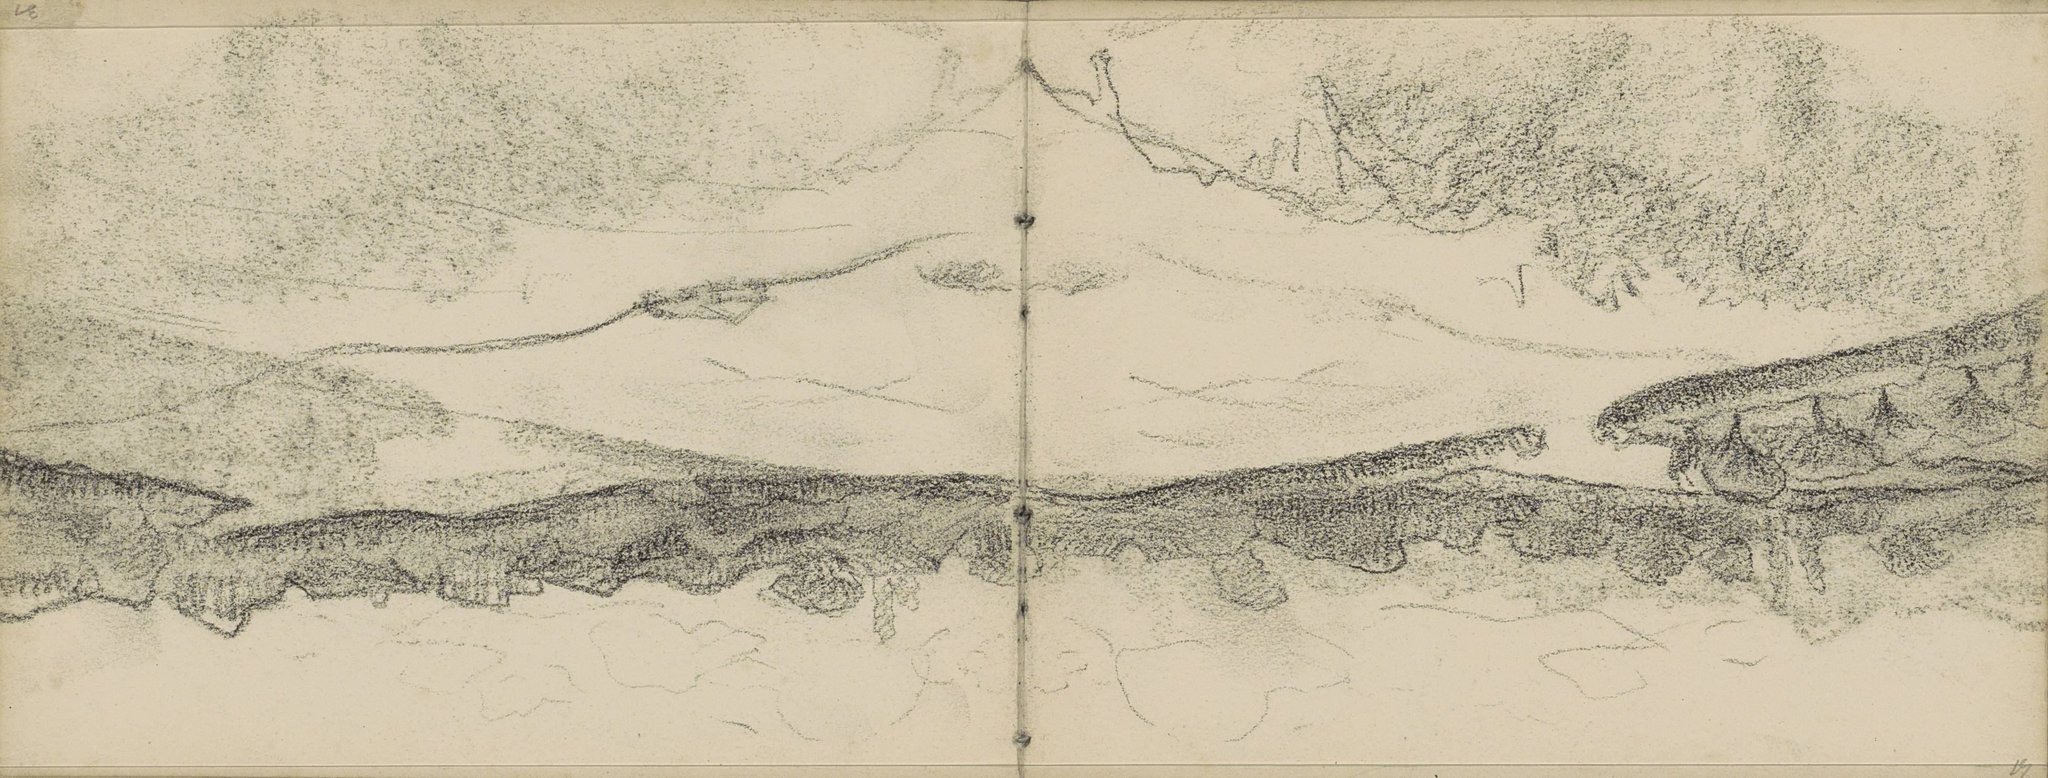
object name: sketchbook leaf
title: Heuvellandschap met bomen en bebouwing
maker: hermannus adrianus van oosterzee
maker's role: draughtsman, painter, print maker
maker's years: 1863-1933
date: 1893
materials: chalk, paper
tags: city-view, and landscape with man-made constructions, low hill country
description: Blad 16 verso en 17 recto uit een schetsboek met 23 bladen.